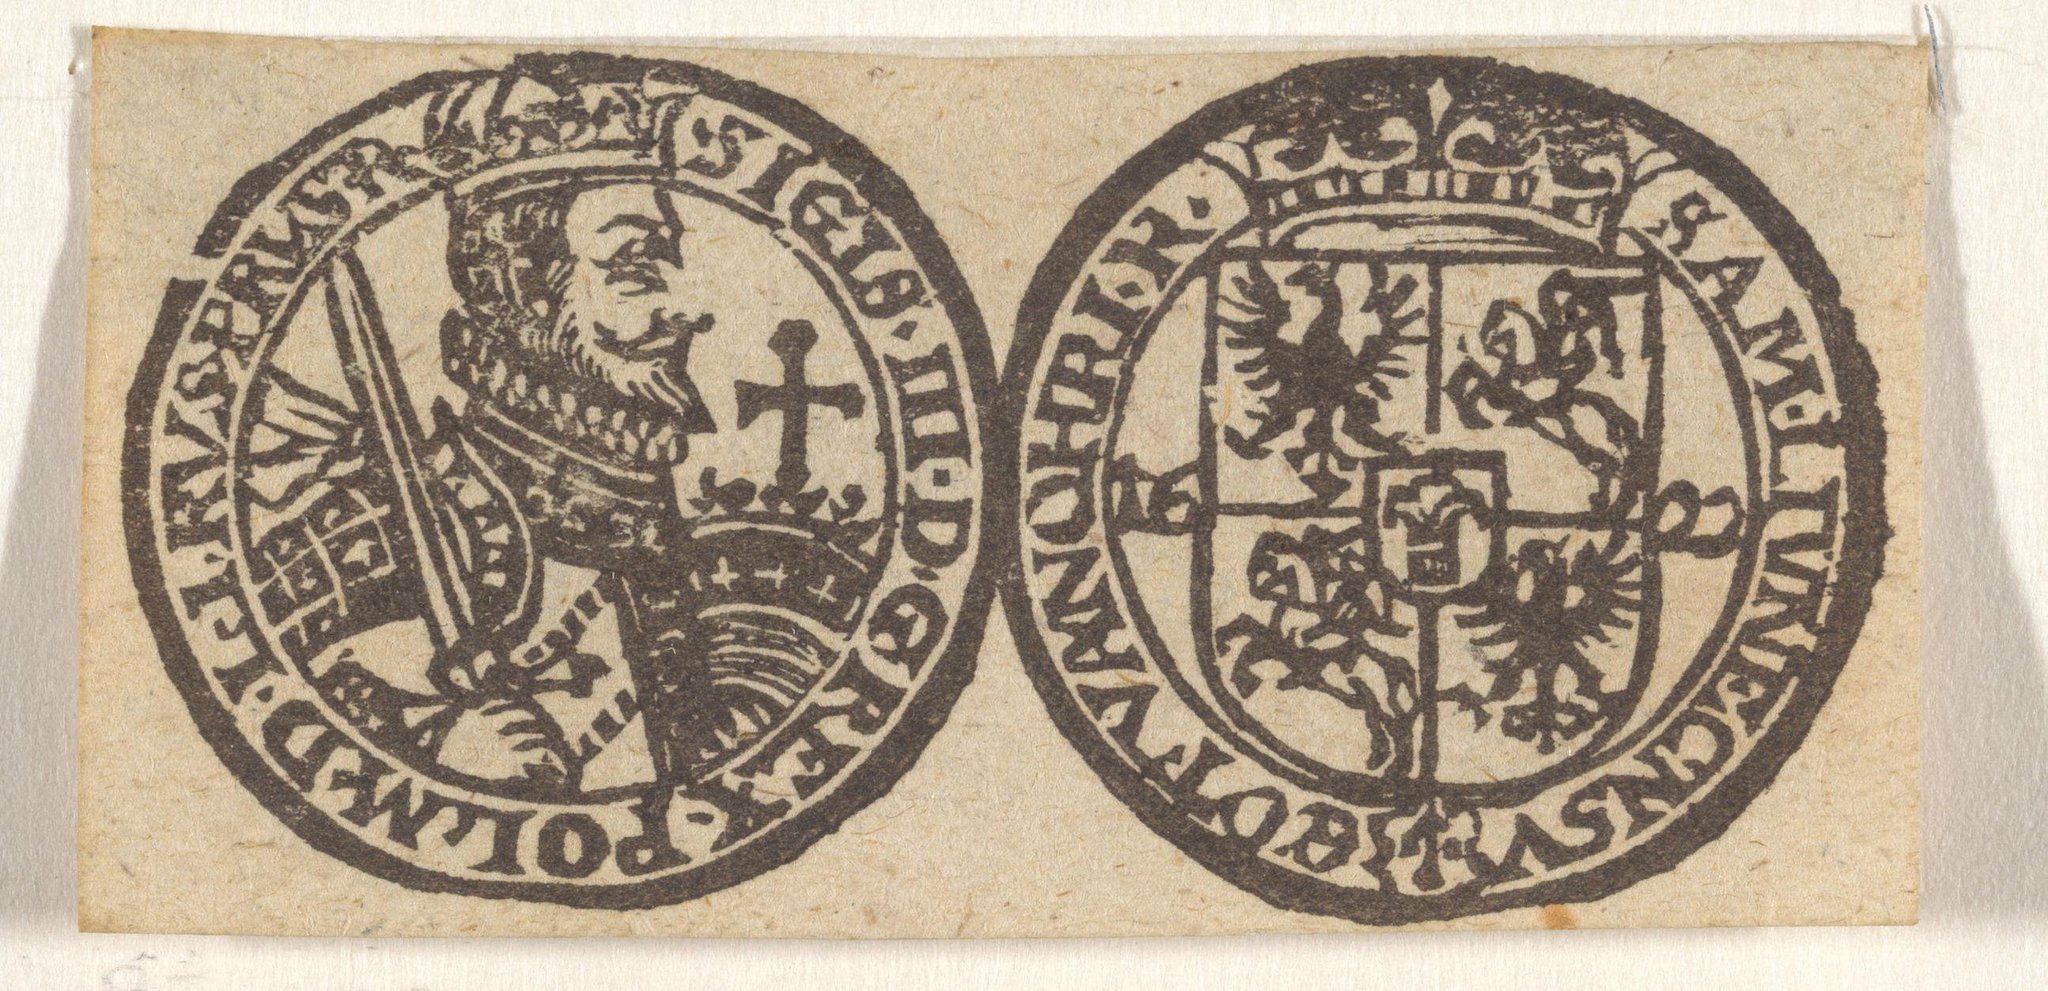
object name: print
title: Penning met portret van Sigismund III, koning van Polen en Zweden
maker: Anonymous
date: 1622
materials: paper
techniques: woodcut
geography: netherlands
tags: sigismund iii (koning van polen), coin, armorial bearing, heraldry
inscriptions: collector's mark: Lugt 240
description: Portret van Sigismund III in een cirkel met randschrift links. Zijn wapen met een kroon in een cirkel met randschrift rechts.